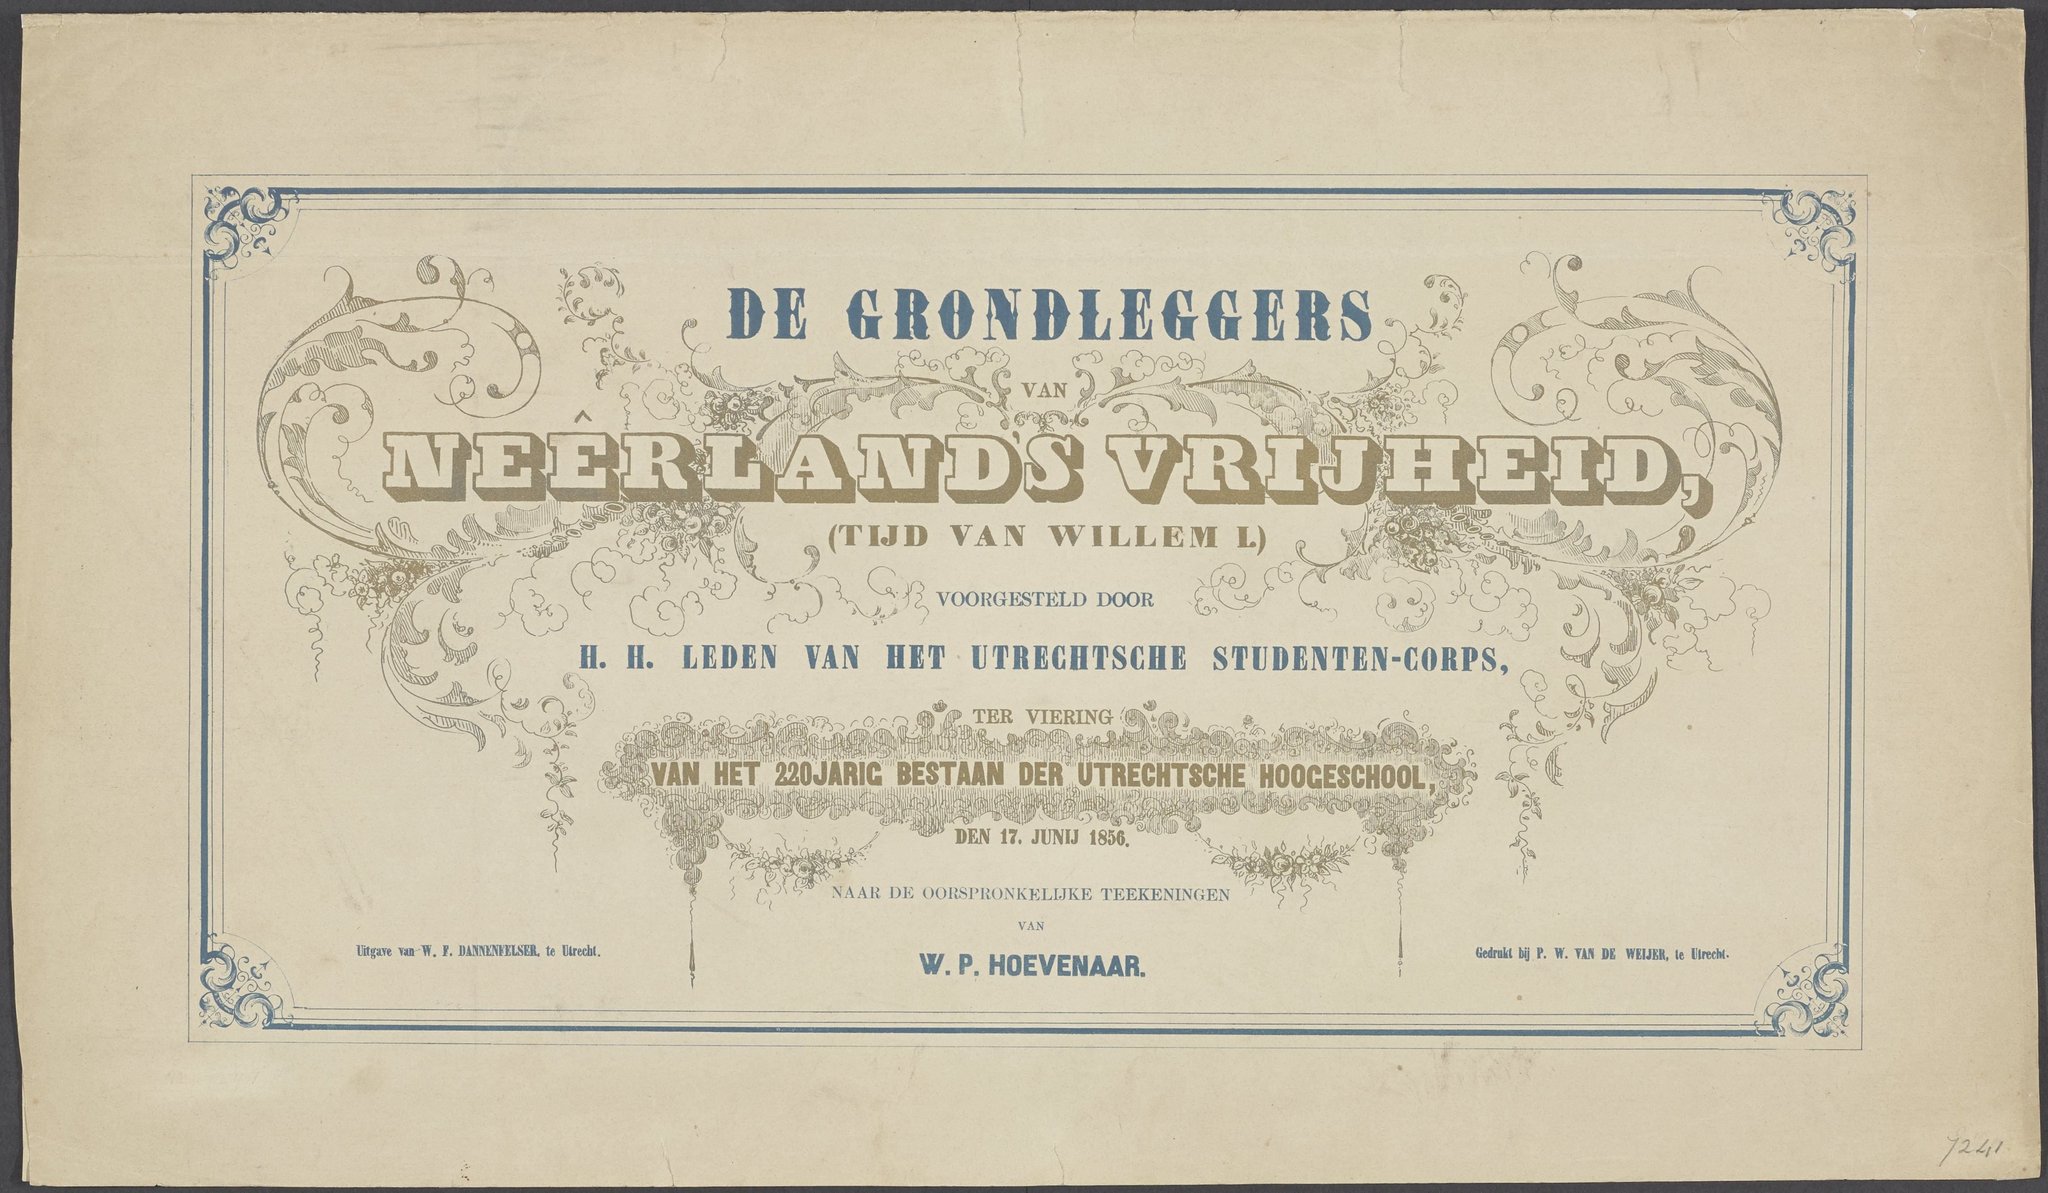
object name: wrapper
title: Omslag voor serie prenten van de Utrechtse maskerade, 1856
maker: pieter wilhelmus van de weijer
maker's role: print maker, printer, publisher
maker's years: 1816-1880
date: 1856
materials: paper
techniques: lithograph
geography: utrecht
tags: delft, william i (prince of orange), students' pageant, costumes used in pageants, utrecht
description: Omslag voor de groep van vijf platen met verklaring van de historische optocht in maskerade opgevoerd door de studenten van de Utrechtse Hogeschool op 17 juni 1856 ter gelegenheid van de viering van haar 220-jarige bestaan.